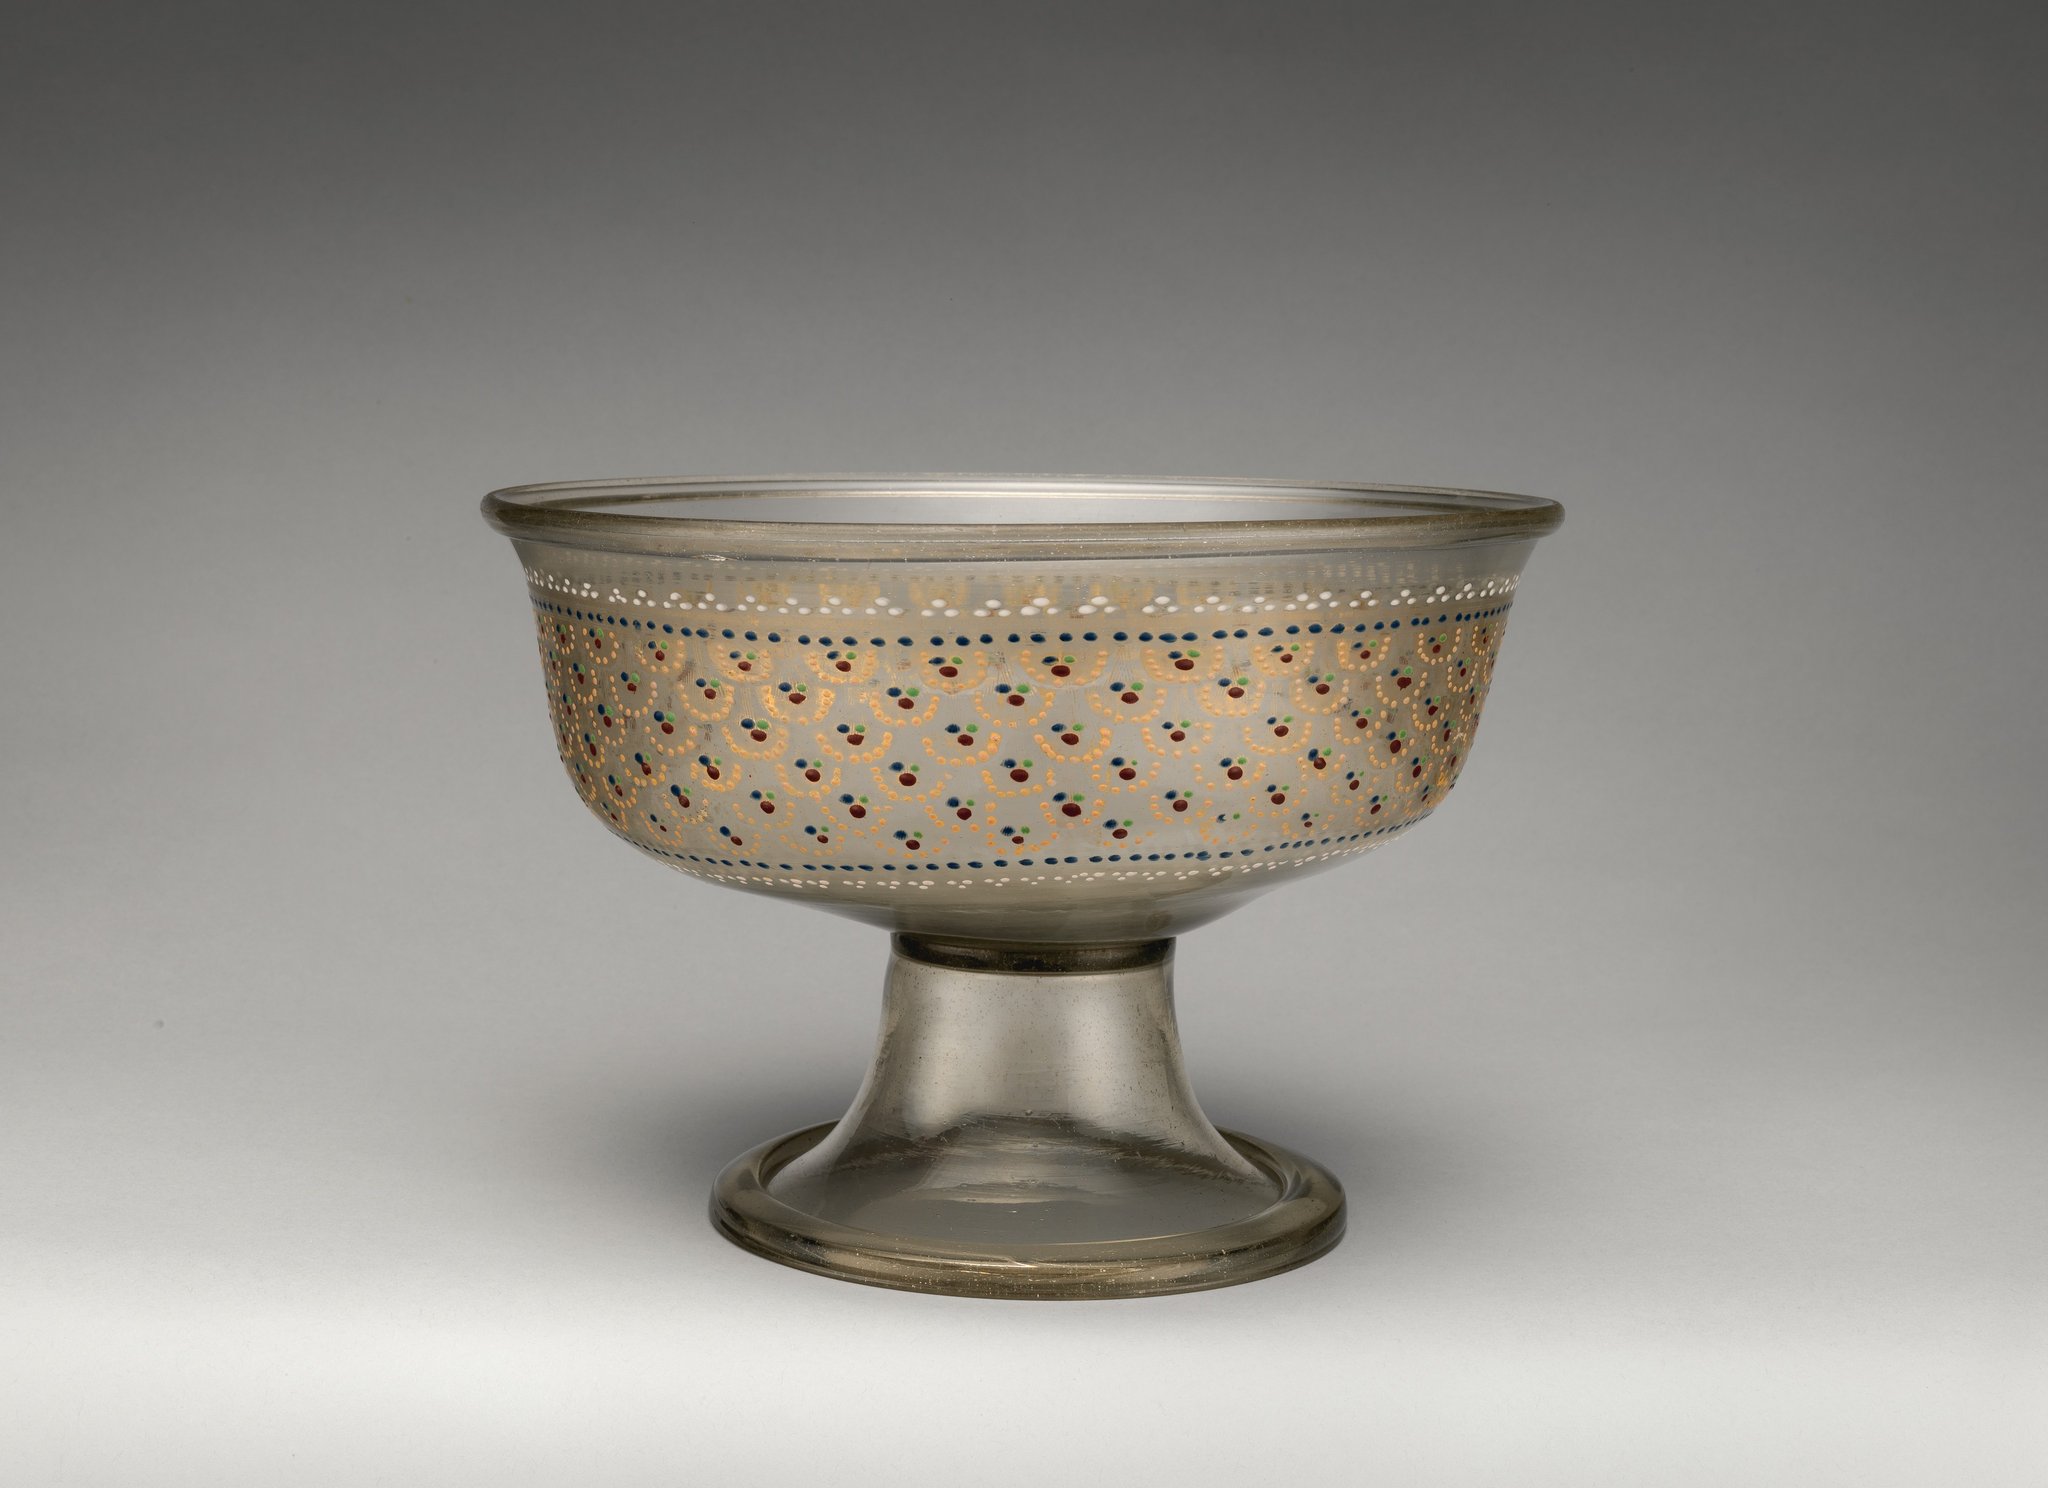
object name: bowl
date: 1500-1520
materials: gilt, glass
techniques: enamel